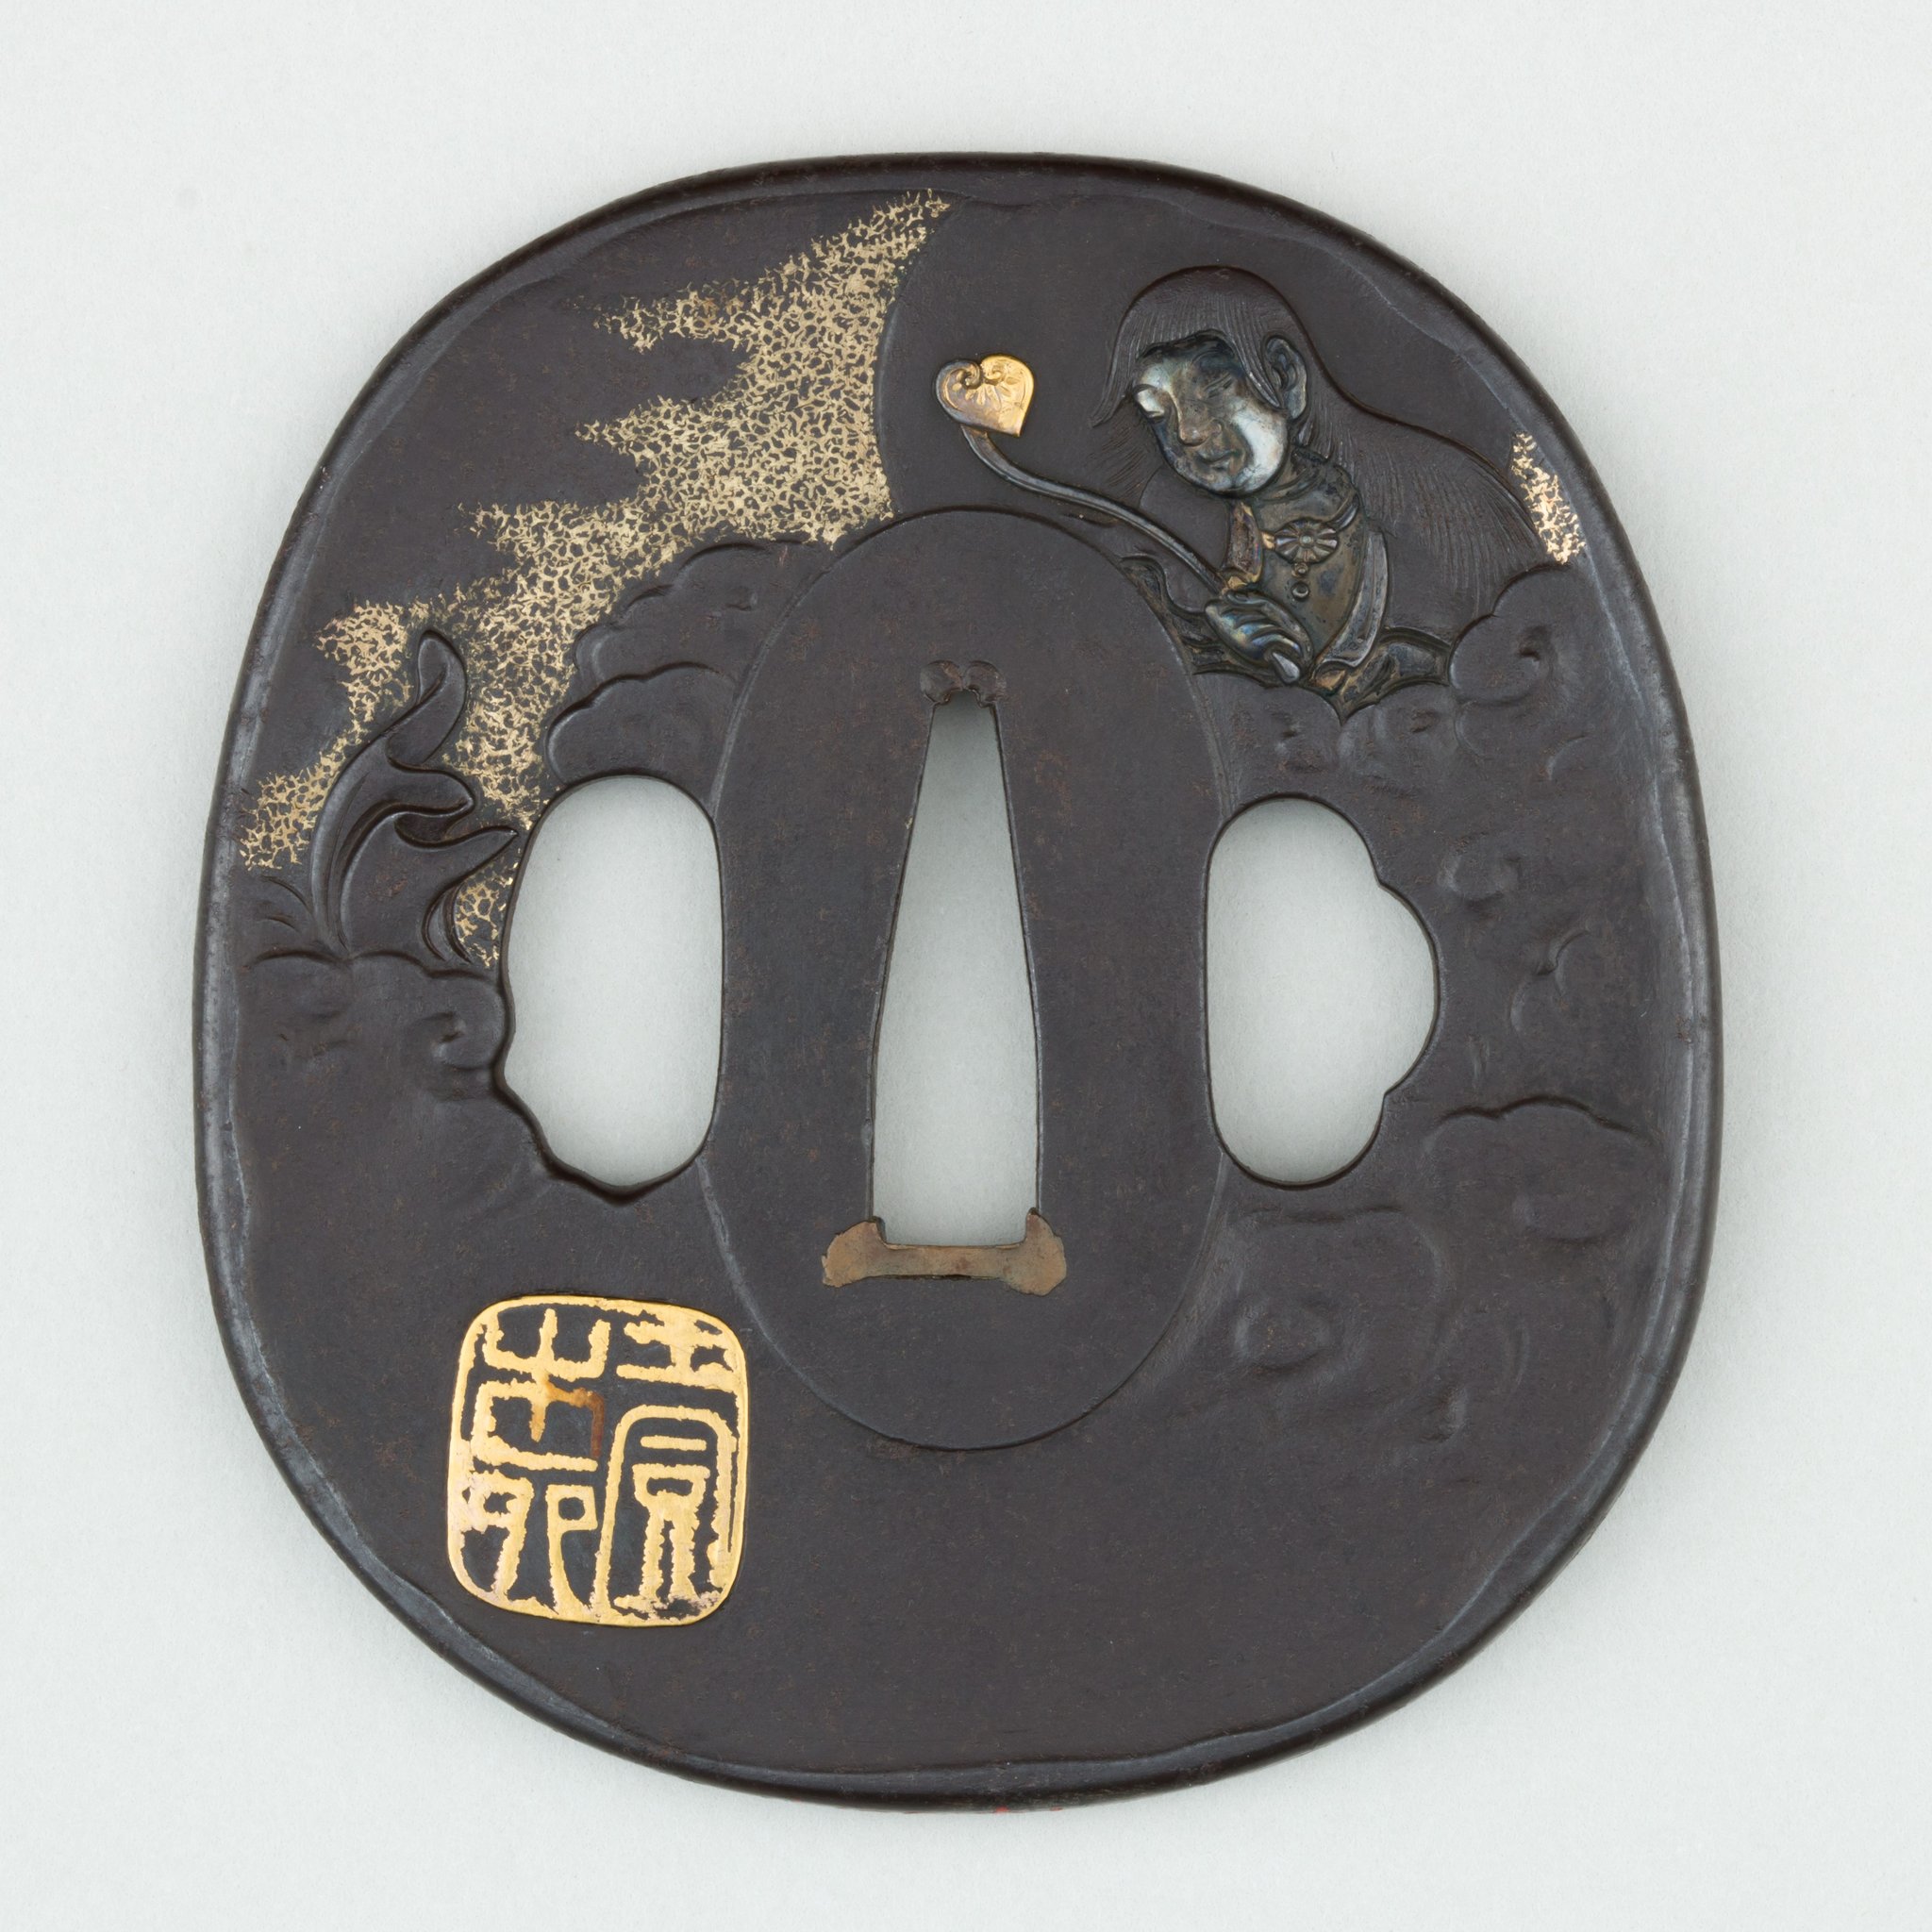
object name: sword guard tsuba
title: Sword Guard (Tsuba)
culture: japanese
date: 1701-1800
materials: copper, gold, iron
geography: japan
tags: men,lions